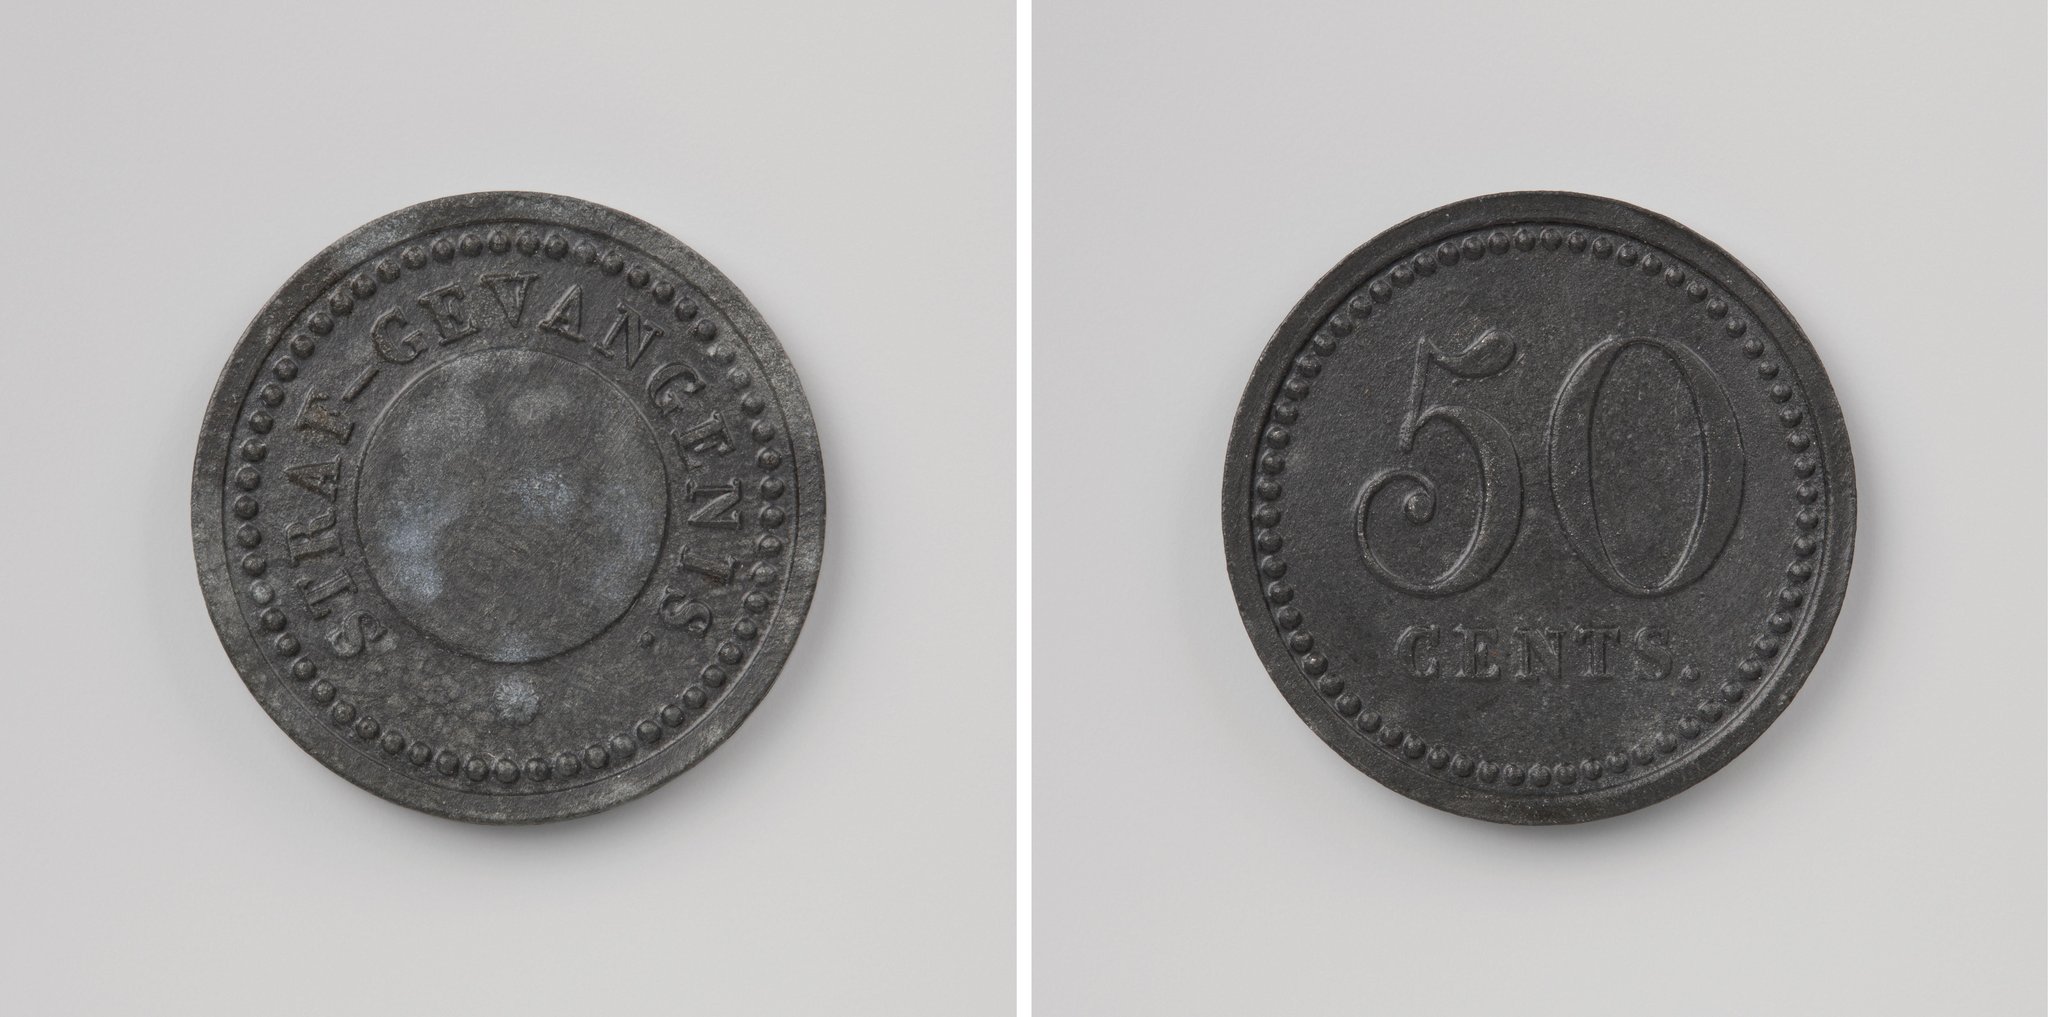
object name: huismunt prison money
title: Huismunt ter waarde van vijftig cents van de strafgevangenis te Woerden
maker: Anonymous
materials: zinc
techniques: striking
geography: utrecht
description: Zinken betaalpenning. Voorzijde: letter L binnen omschrift. Keerzijde: waardeaanduiding